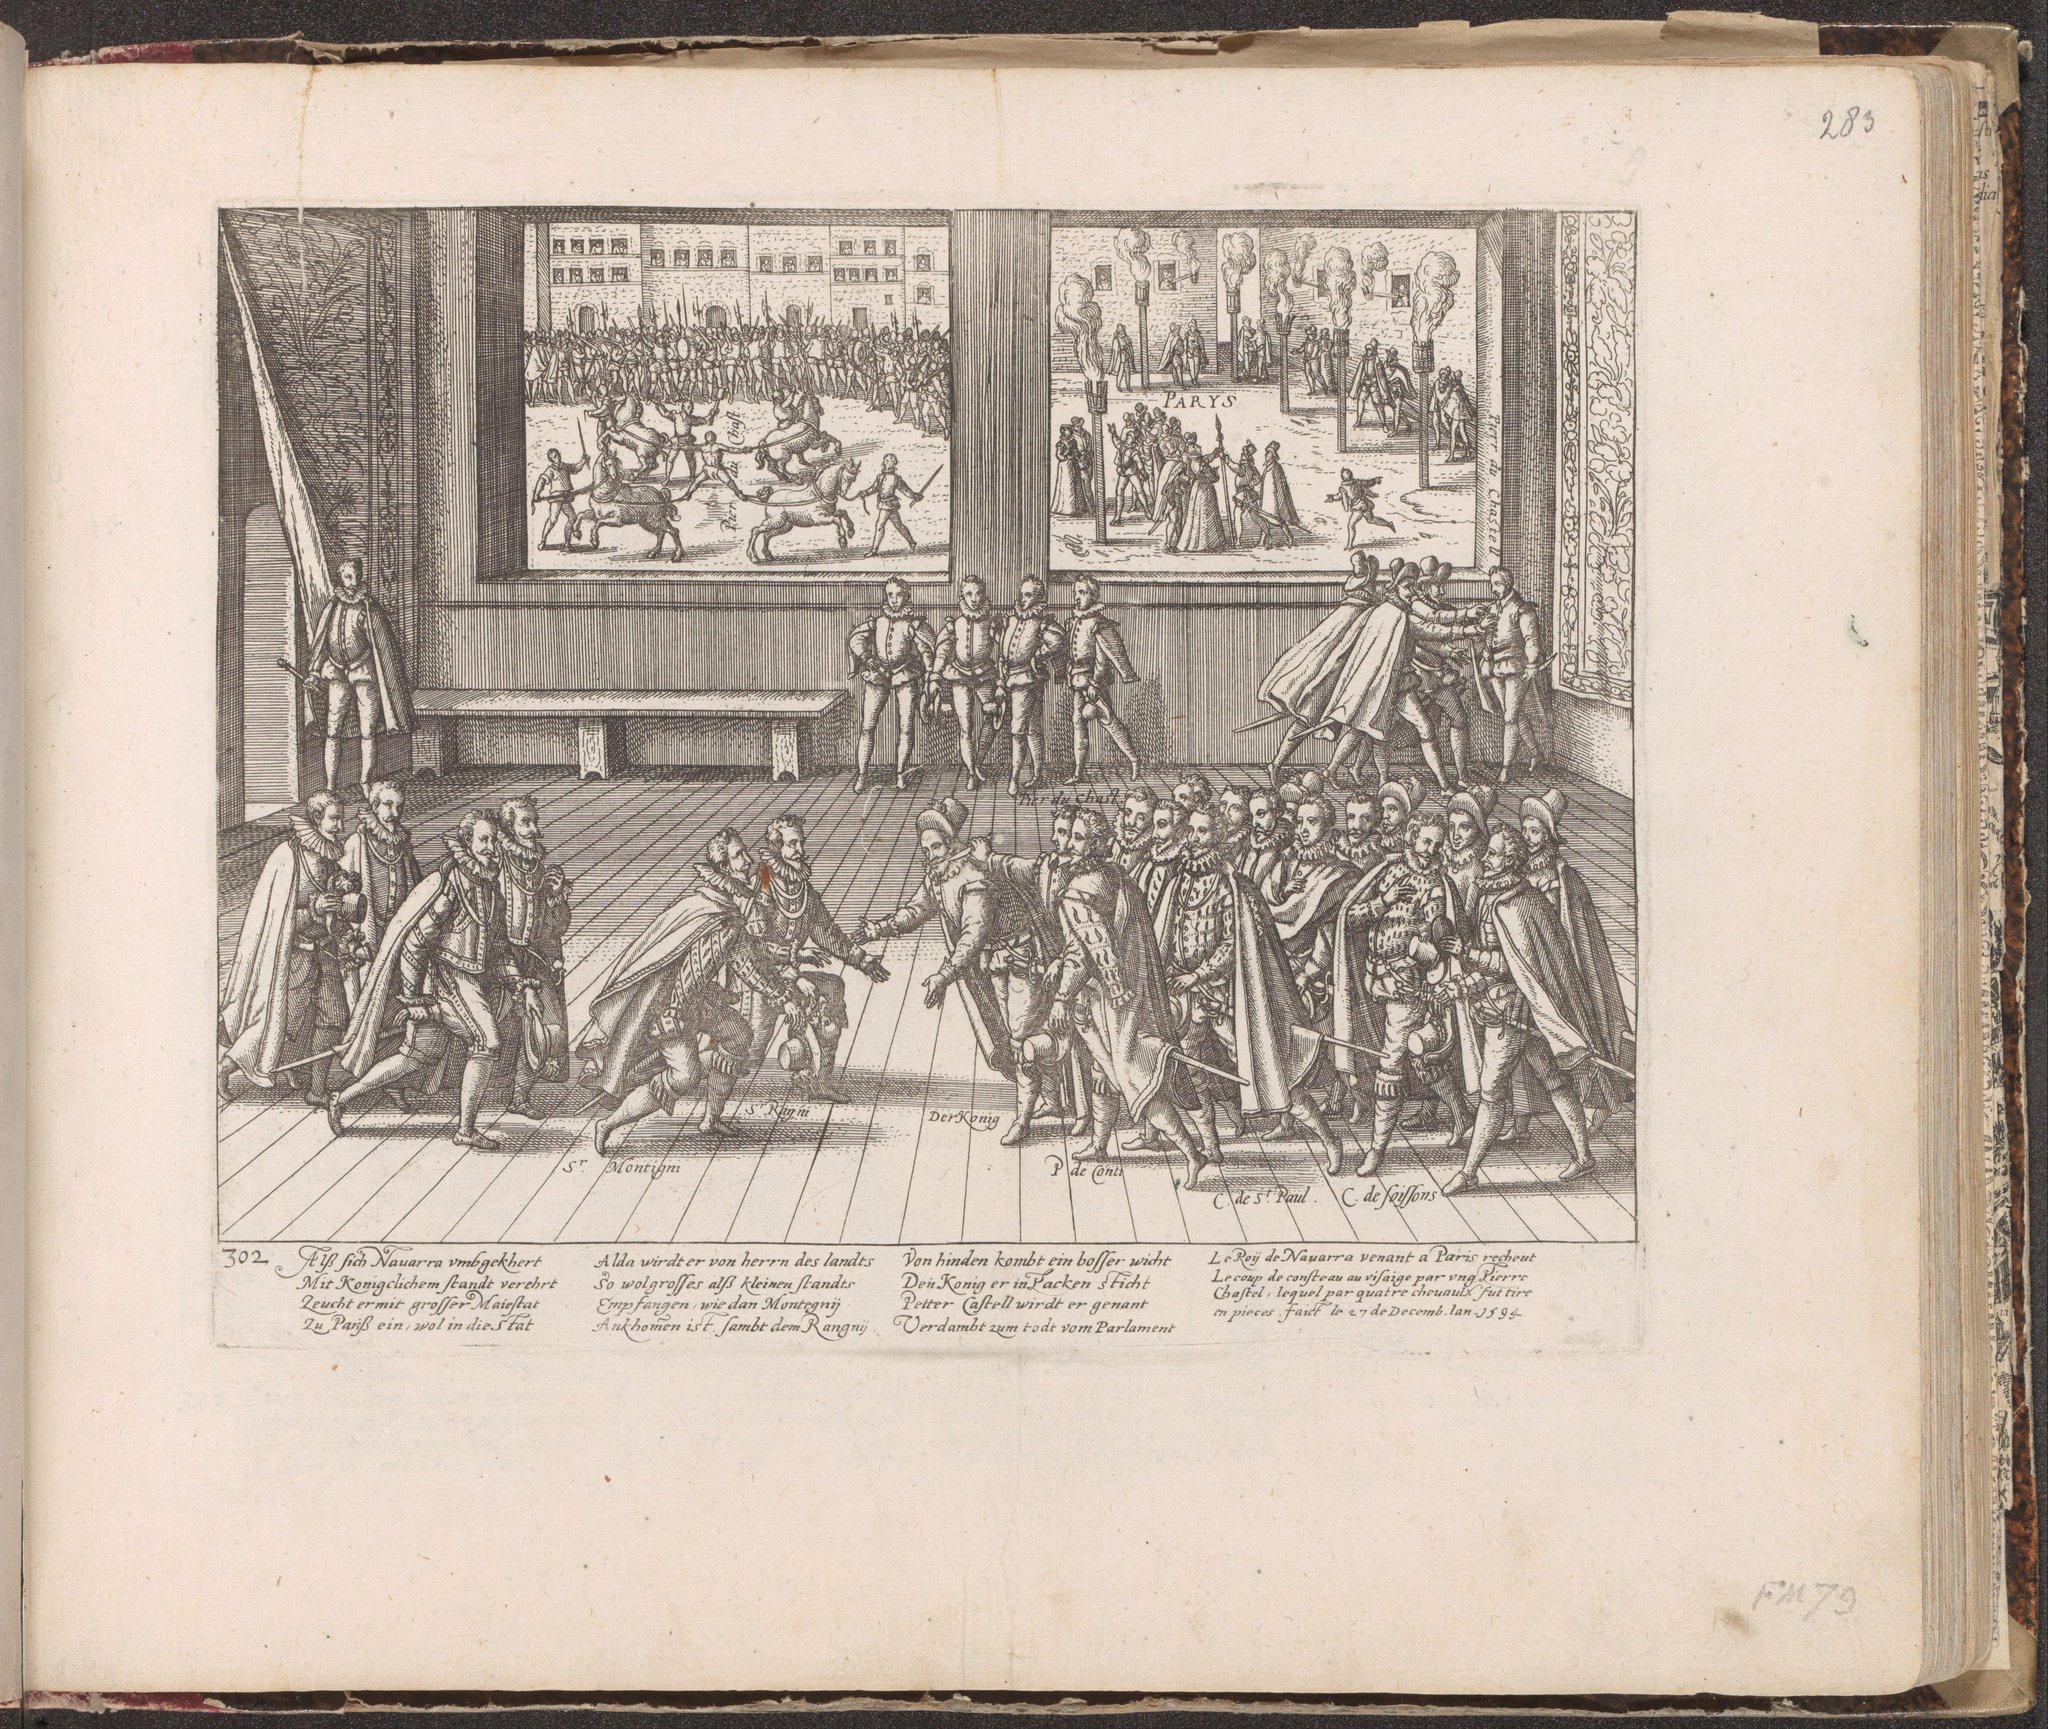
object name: print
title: Aanslag door Jean Châtel op Hendrik IV, 1594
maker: frans hogenberg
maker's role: print maker, publisher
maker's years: 1538-1590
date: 1594-1612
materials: paper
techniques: etching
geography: cologne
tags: paris, hendrik iv (koning van frankrijk en navarra), violent death by quartering, attempt, political murder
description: Aanslag door Jean Châtel op Hendrik IV, 27 december 1594. In een interieur steekt Châtel de koning met een mes. Op de achtergrond wordt Châtel gevierendeeld. Met onderschrift van 12 regels in het Duits en 1 regel in het Frans. Linksonder genummerd: 302. De prent maakt deel uit van een album.